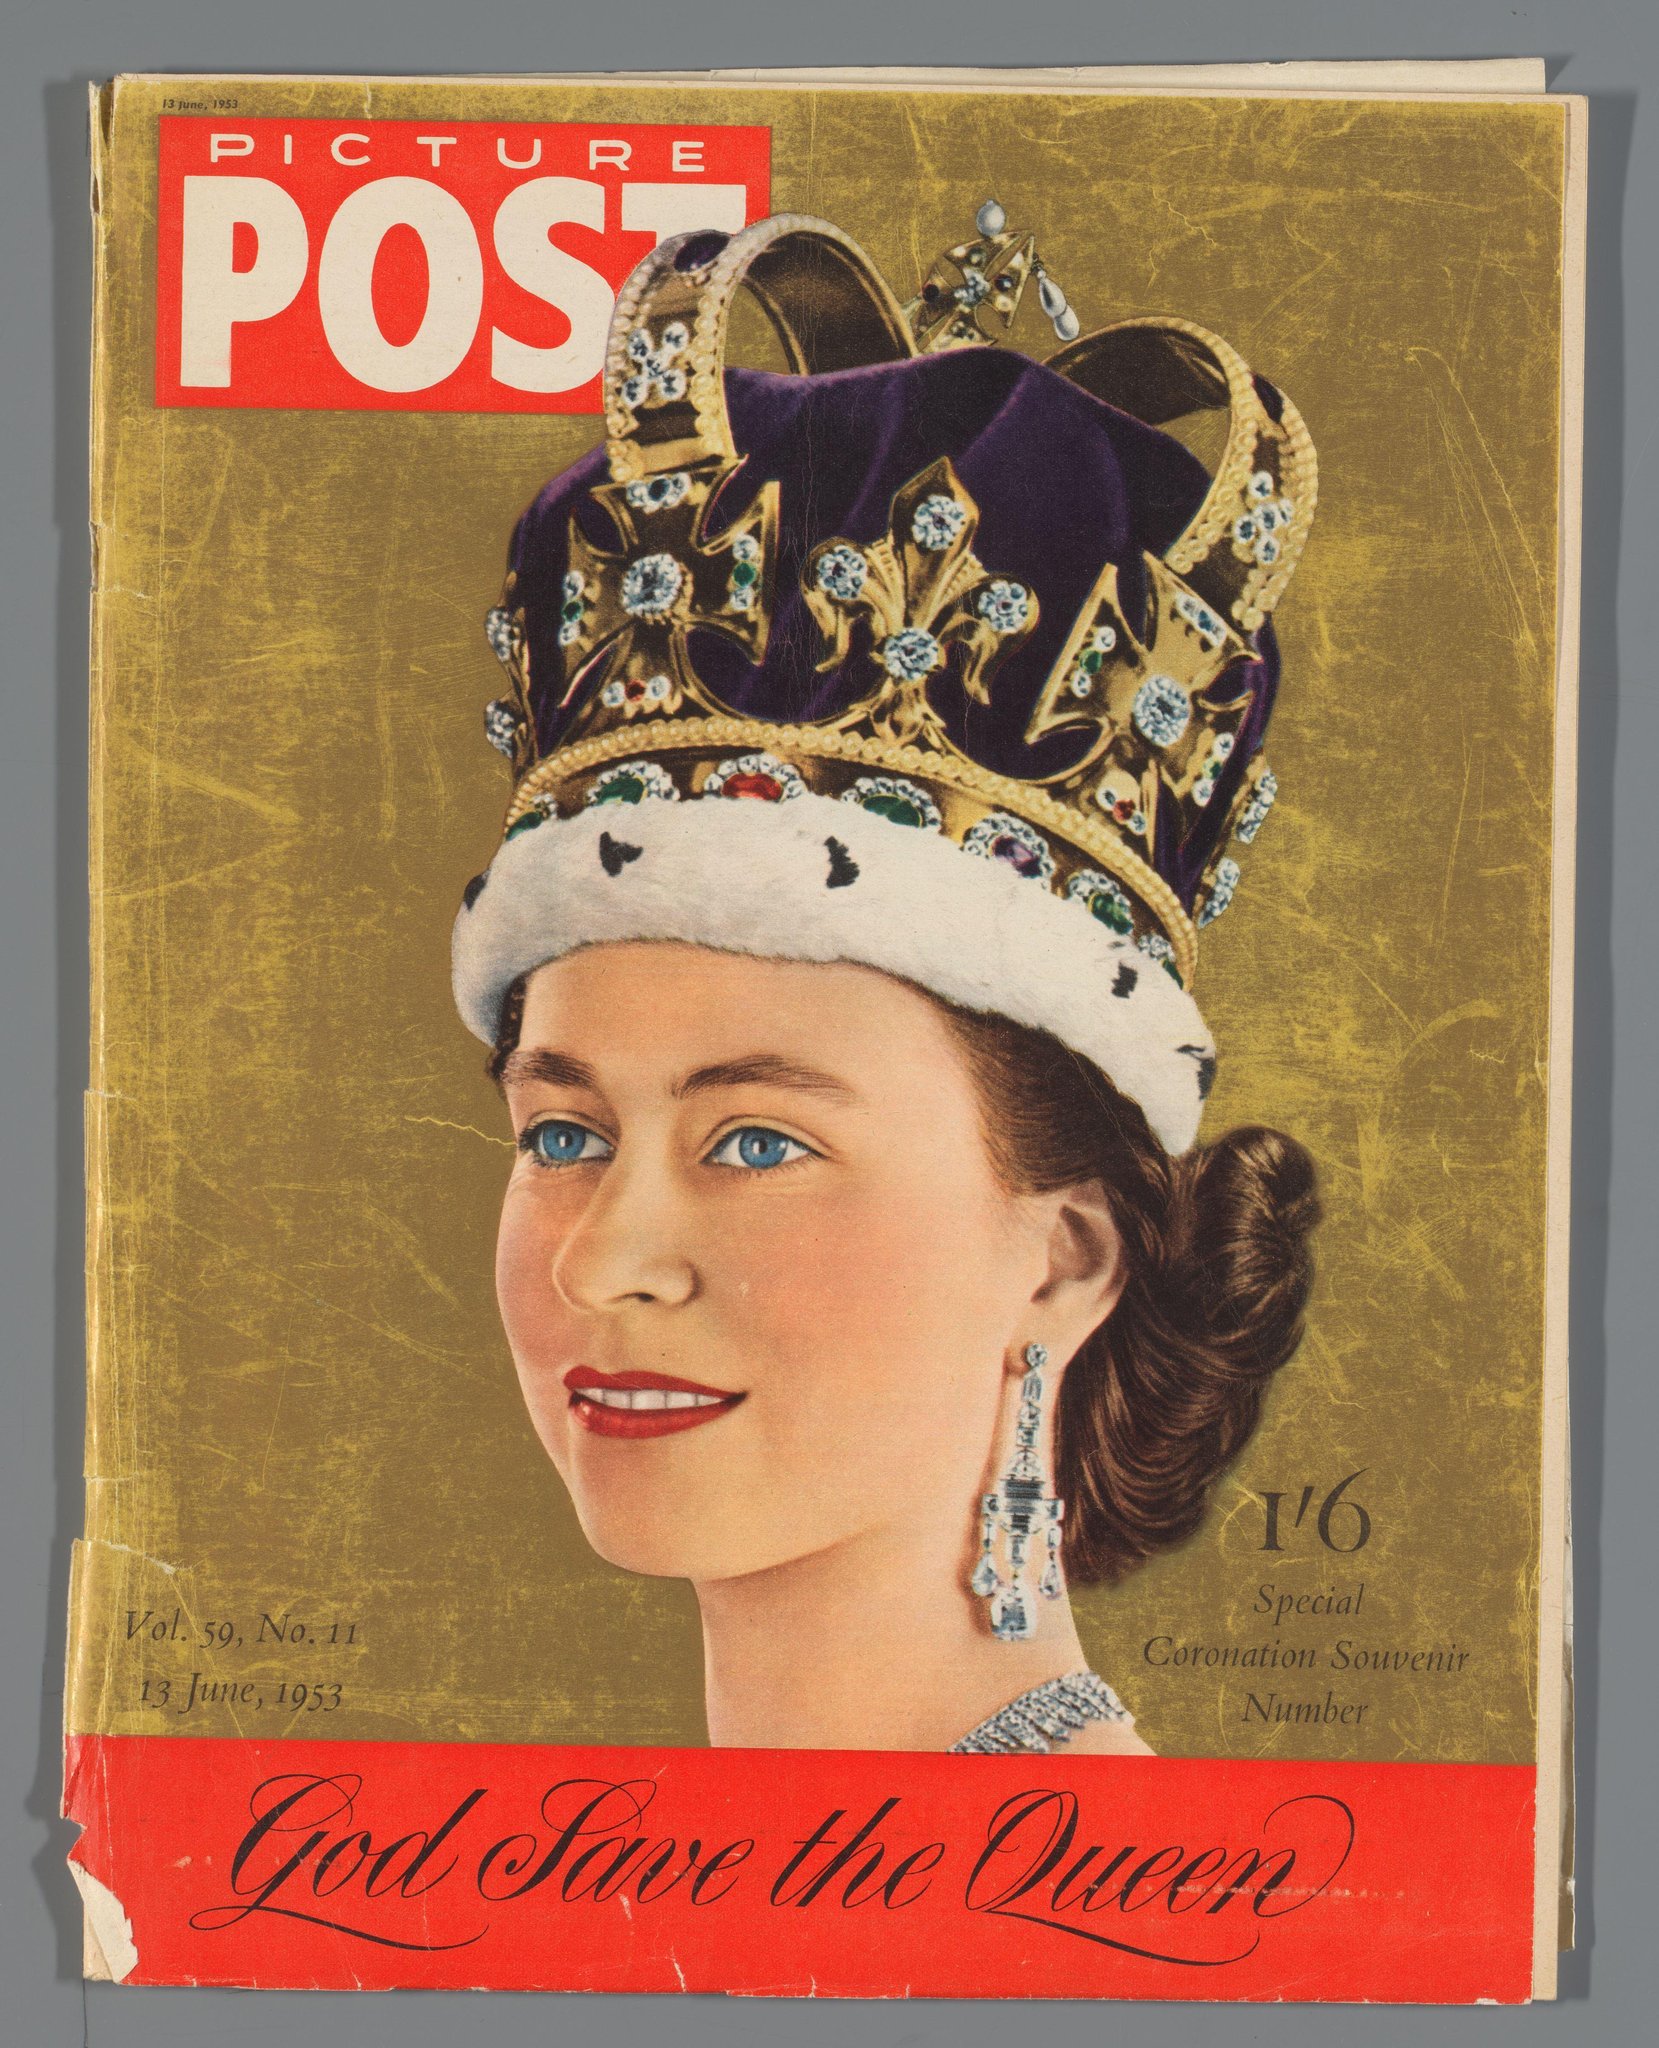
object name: print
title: Exemplaar van de speciale editie van de Picture Post tgv de kroning van koningin Elizabeth II, 13 juni 1953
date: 1953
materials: paper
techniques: printed materials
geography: london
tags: london, coronation of a ruler - bb - female ruler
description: Exemplaar van de speciale editie van het tijdschrift 'Picture Post' van 13 juni 1953, ter gelegenheid van de kroning van koningin Elizabeth II op 2 juni 1953.